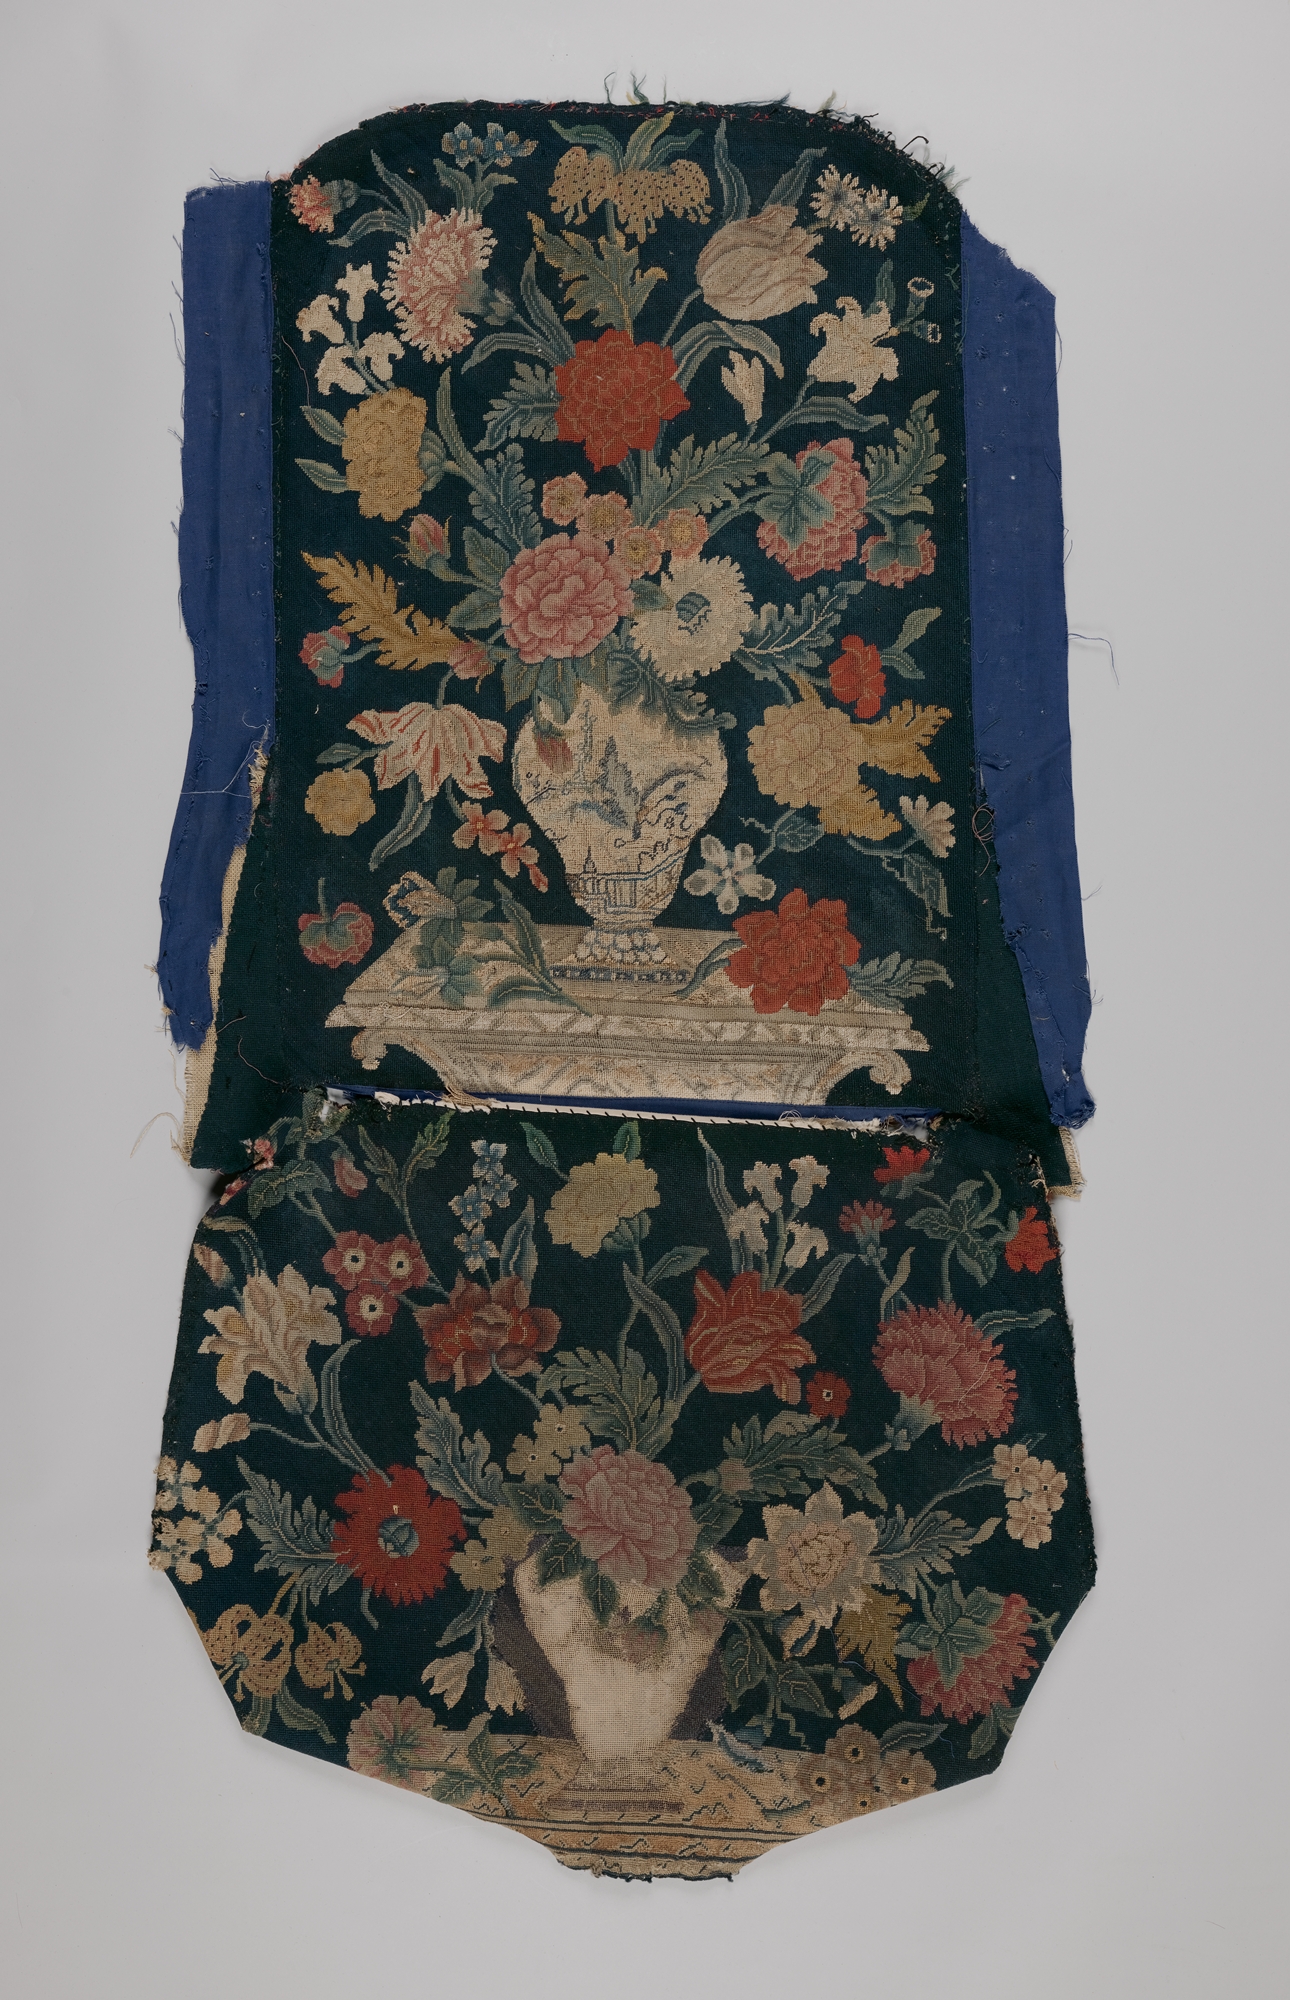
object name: upholstery panel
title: Side chair back and seat cover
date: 1739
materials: canvas, hemp, silk, wool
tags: flowers